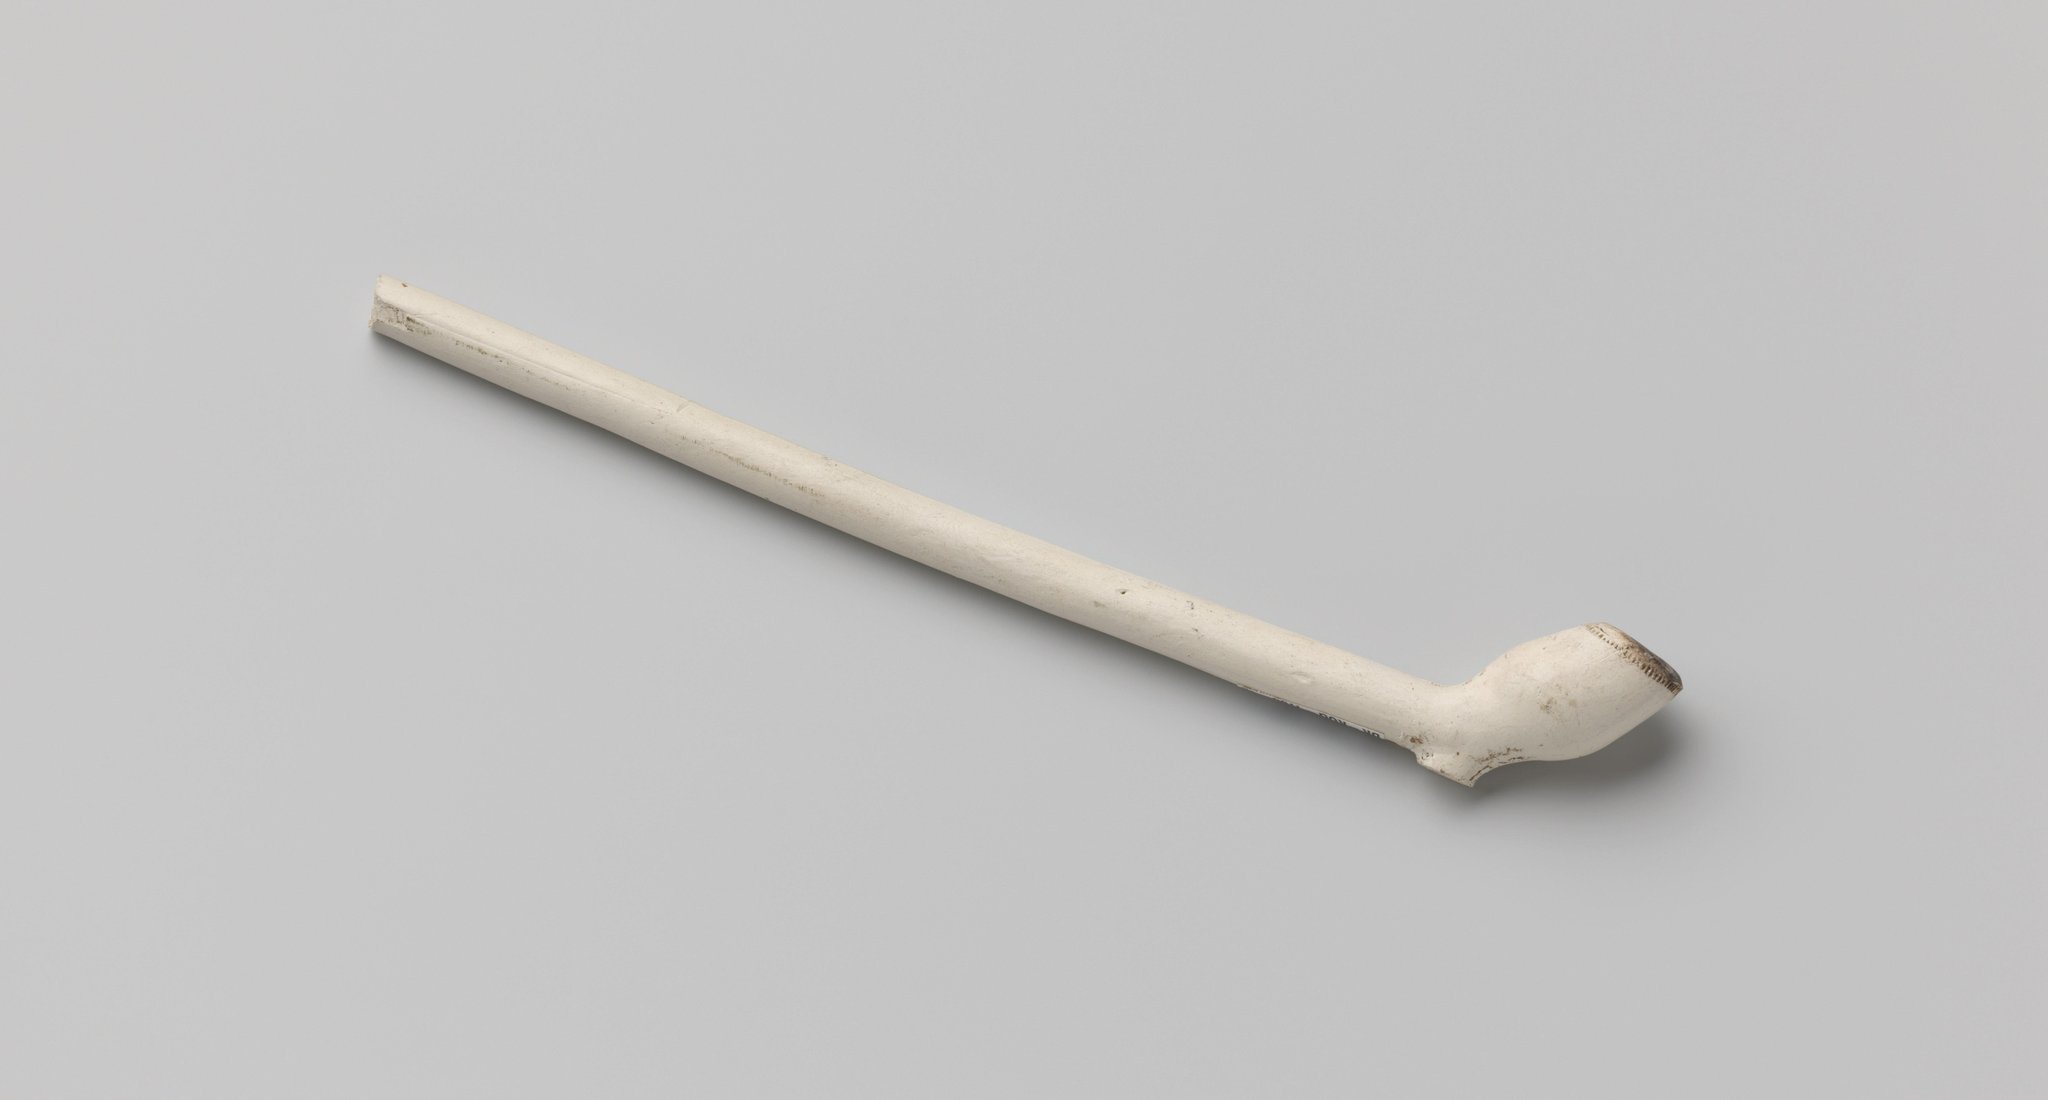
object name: tabakspijp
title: Gemerkte tabakspijp van pijpaarde, beschadigd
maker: Anonymous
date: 1500-1799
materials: clay